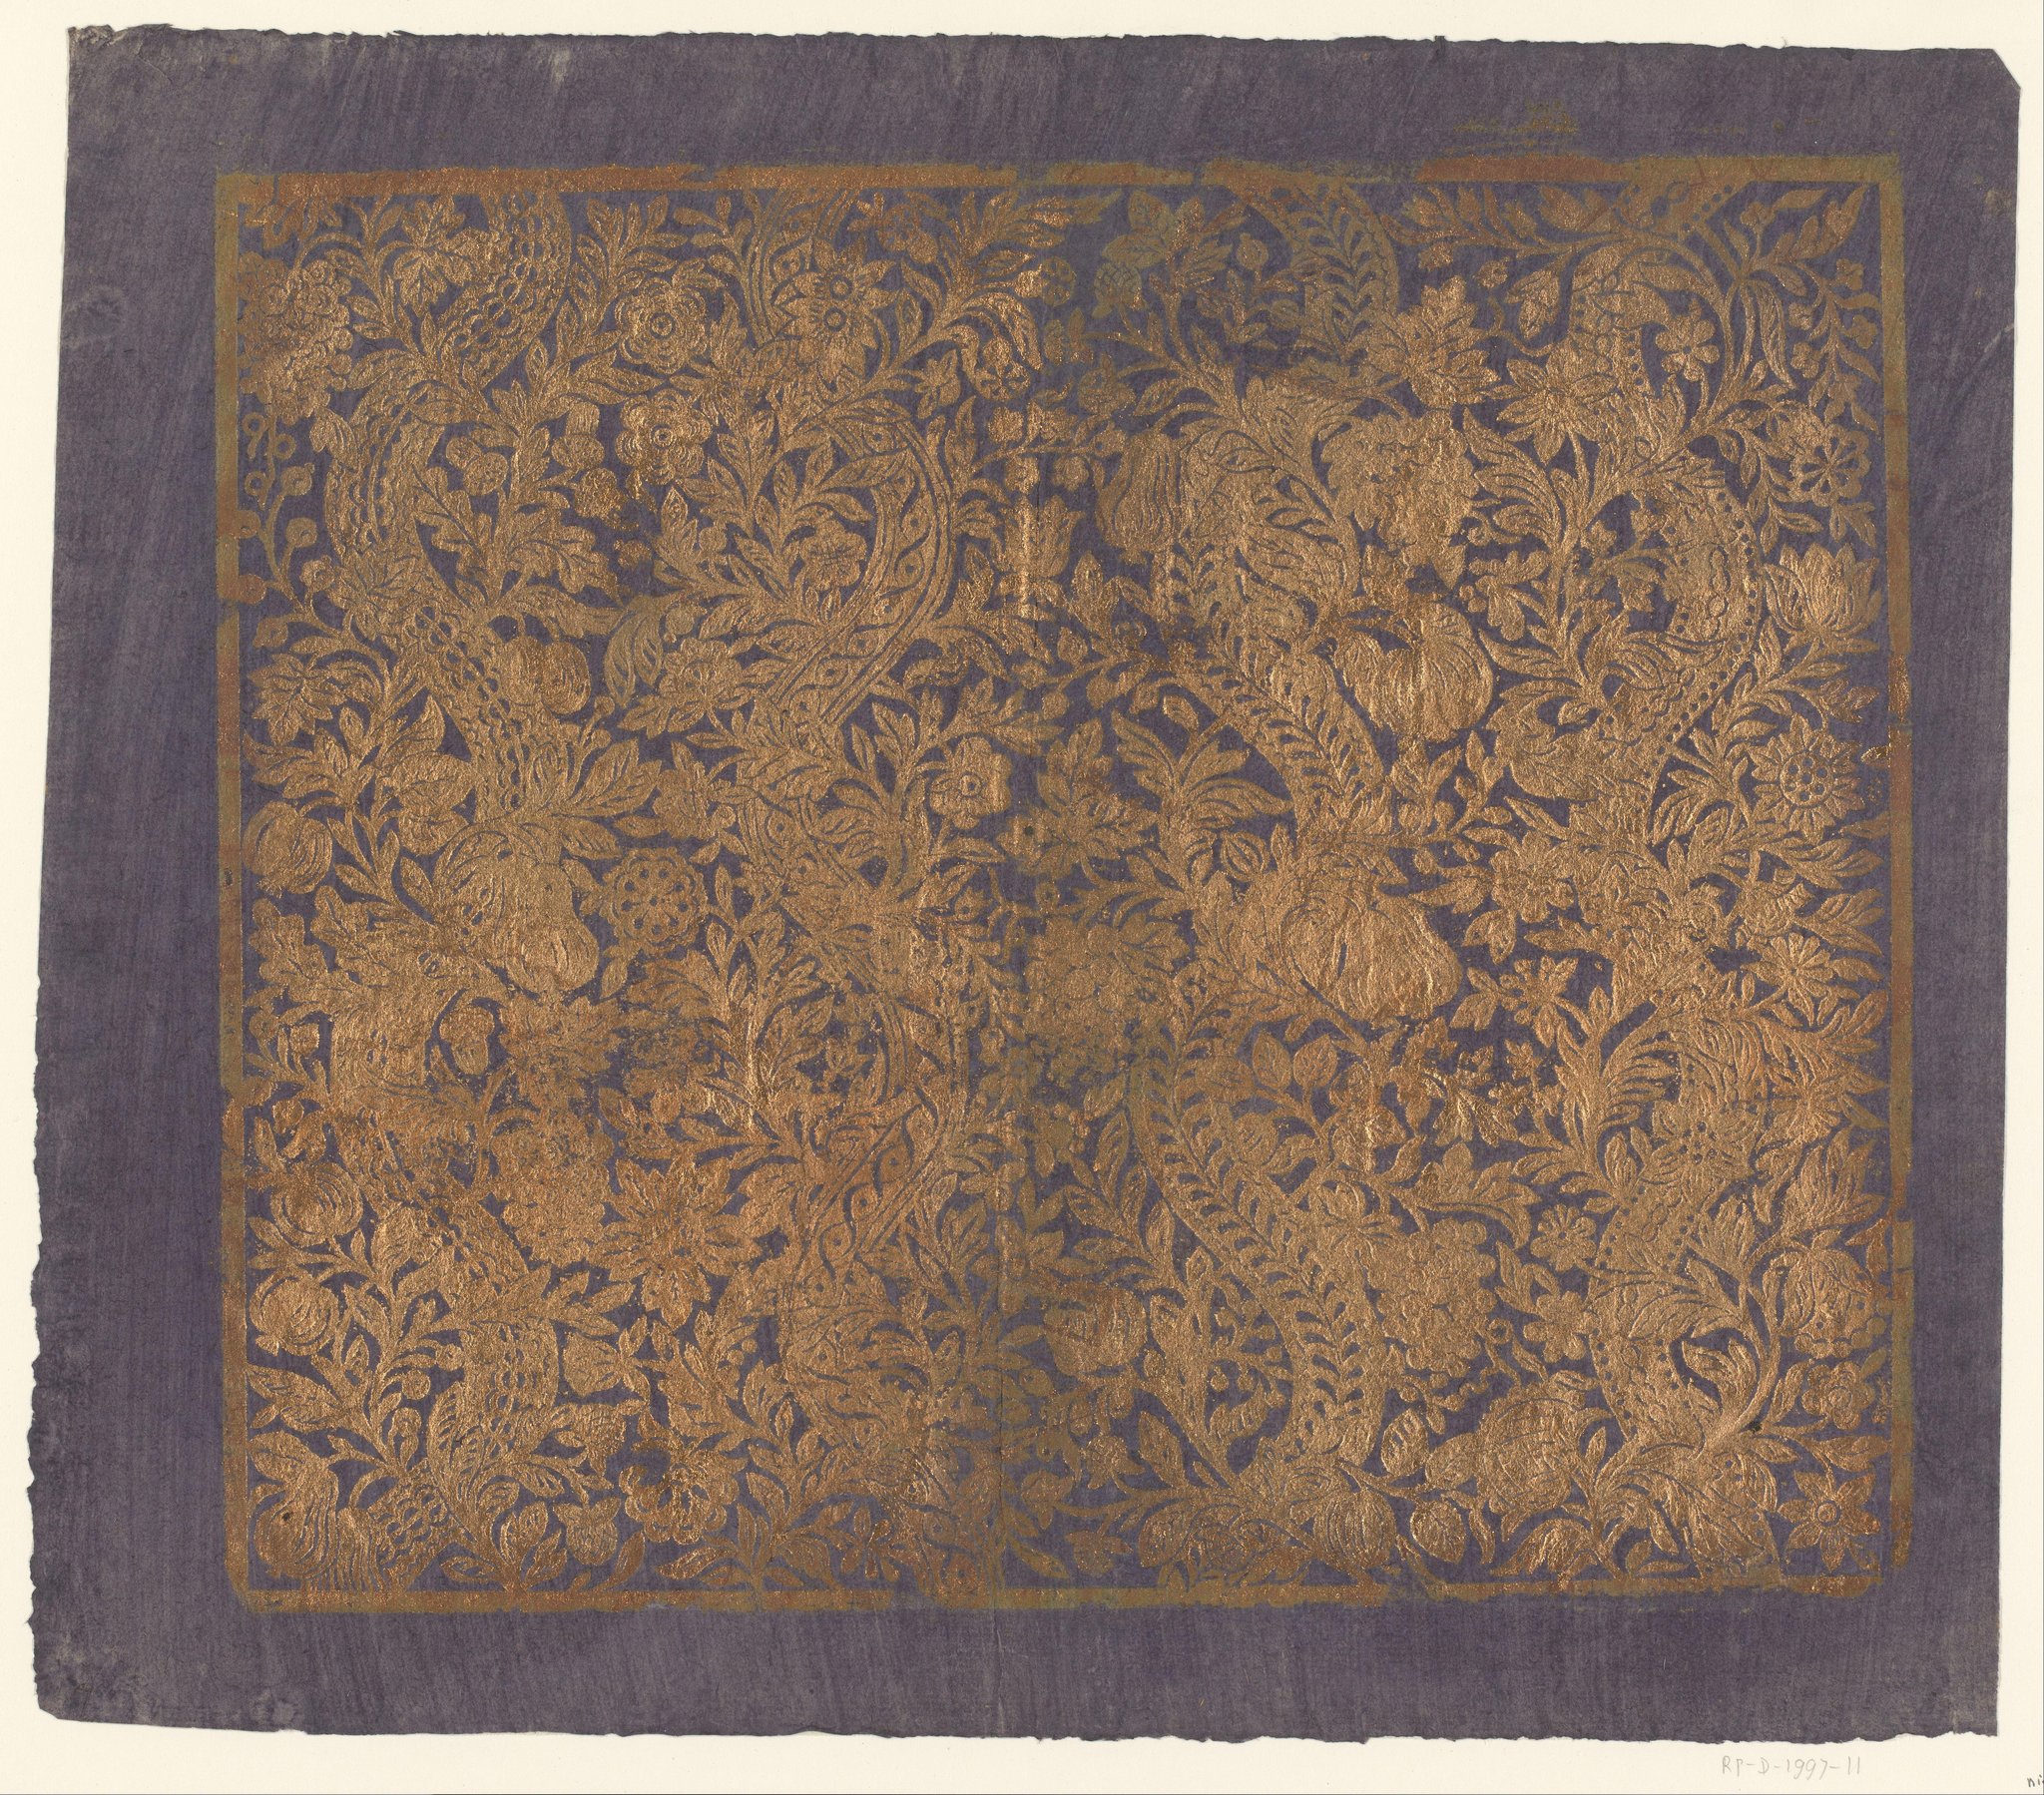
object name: brocade paper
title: Blad met vier slingerende banen omwonden door ranken met bloemen en vruchten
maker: Anonymous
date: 1750-1820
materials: gold leaf, paint, paper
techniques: relief print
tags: ornament derived from plant forms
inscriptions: collector's mark: Lugt 2760, collector's mark: Lugt 2228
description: Blad met vier slingerende kantachtige banen omwonden door ranken met bloemen en vruchten, op regelmatige afstand van elkaar geplaatst.